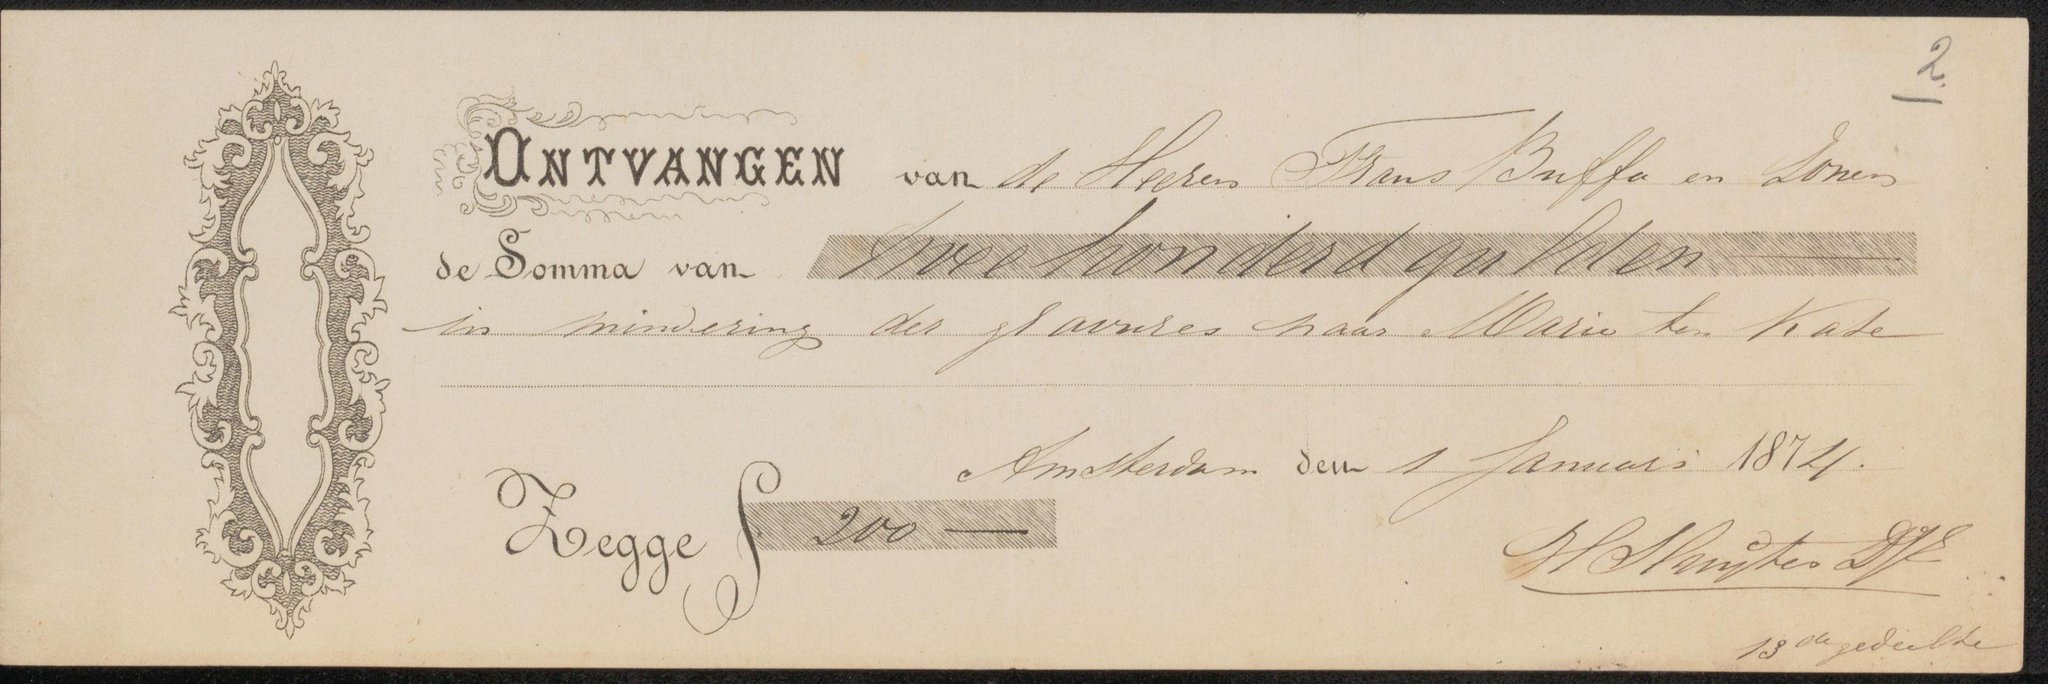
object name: ontvangstbewijs, kwitantie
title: Kwitantie voor Hendrik D. Jzn Sluyter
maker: hendrik d. jzn sluyter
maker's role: print maker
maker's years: 1839-1931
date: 1874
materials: ink, paper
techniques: pen, printing, writing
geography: amsterdam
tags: the hague, painter, print maker, draughtsman, mari ten kate, the graphic arts, money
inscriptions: collector's mark: Lugt 2233